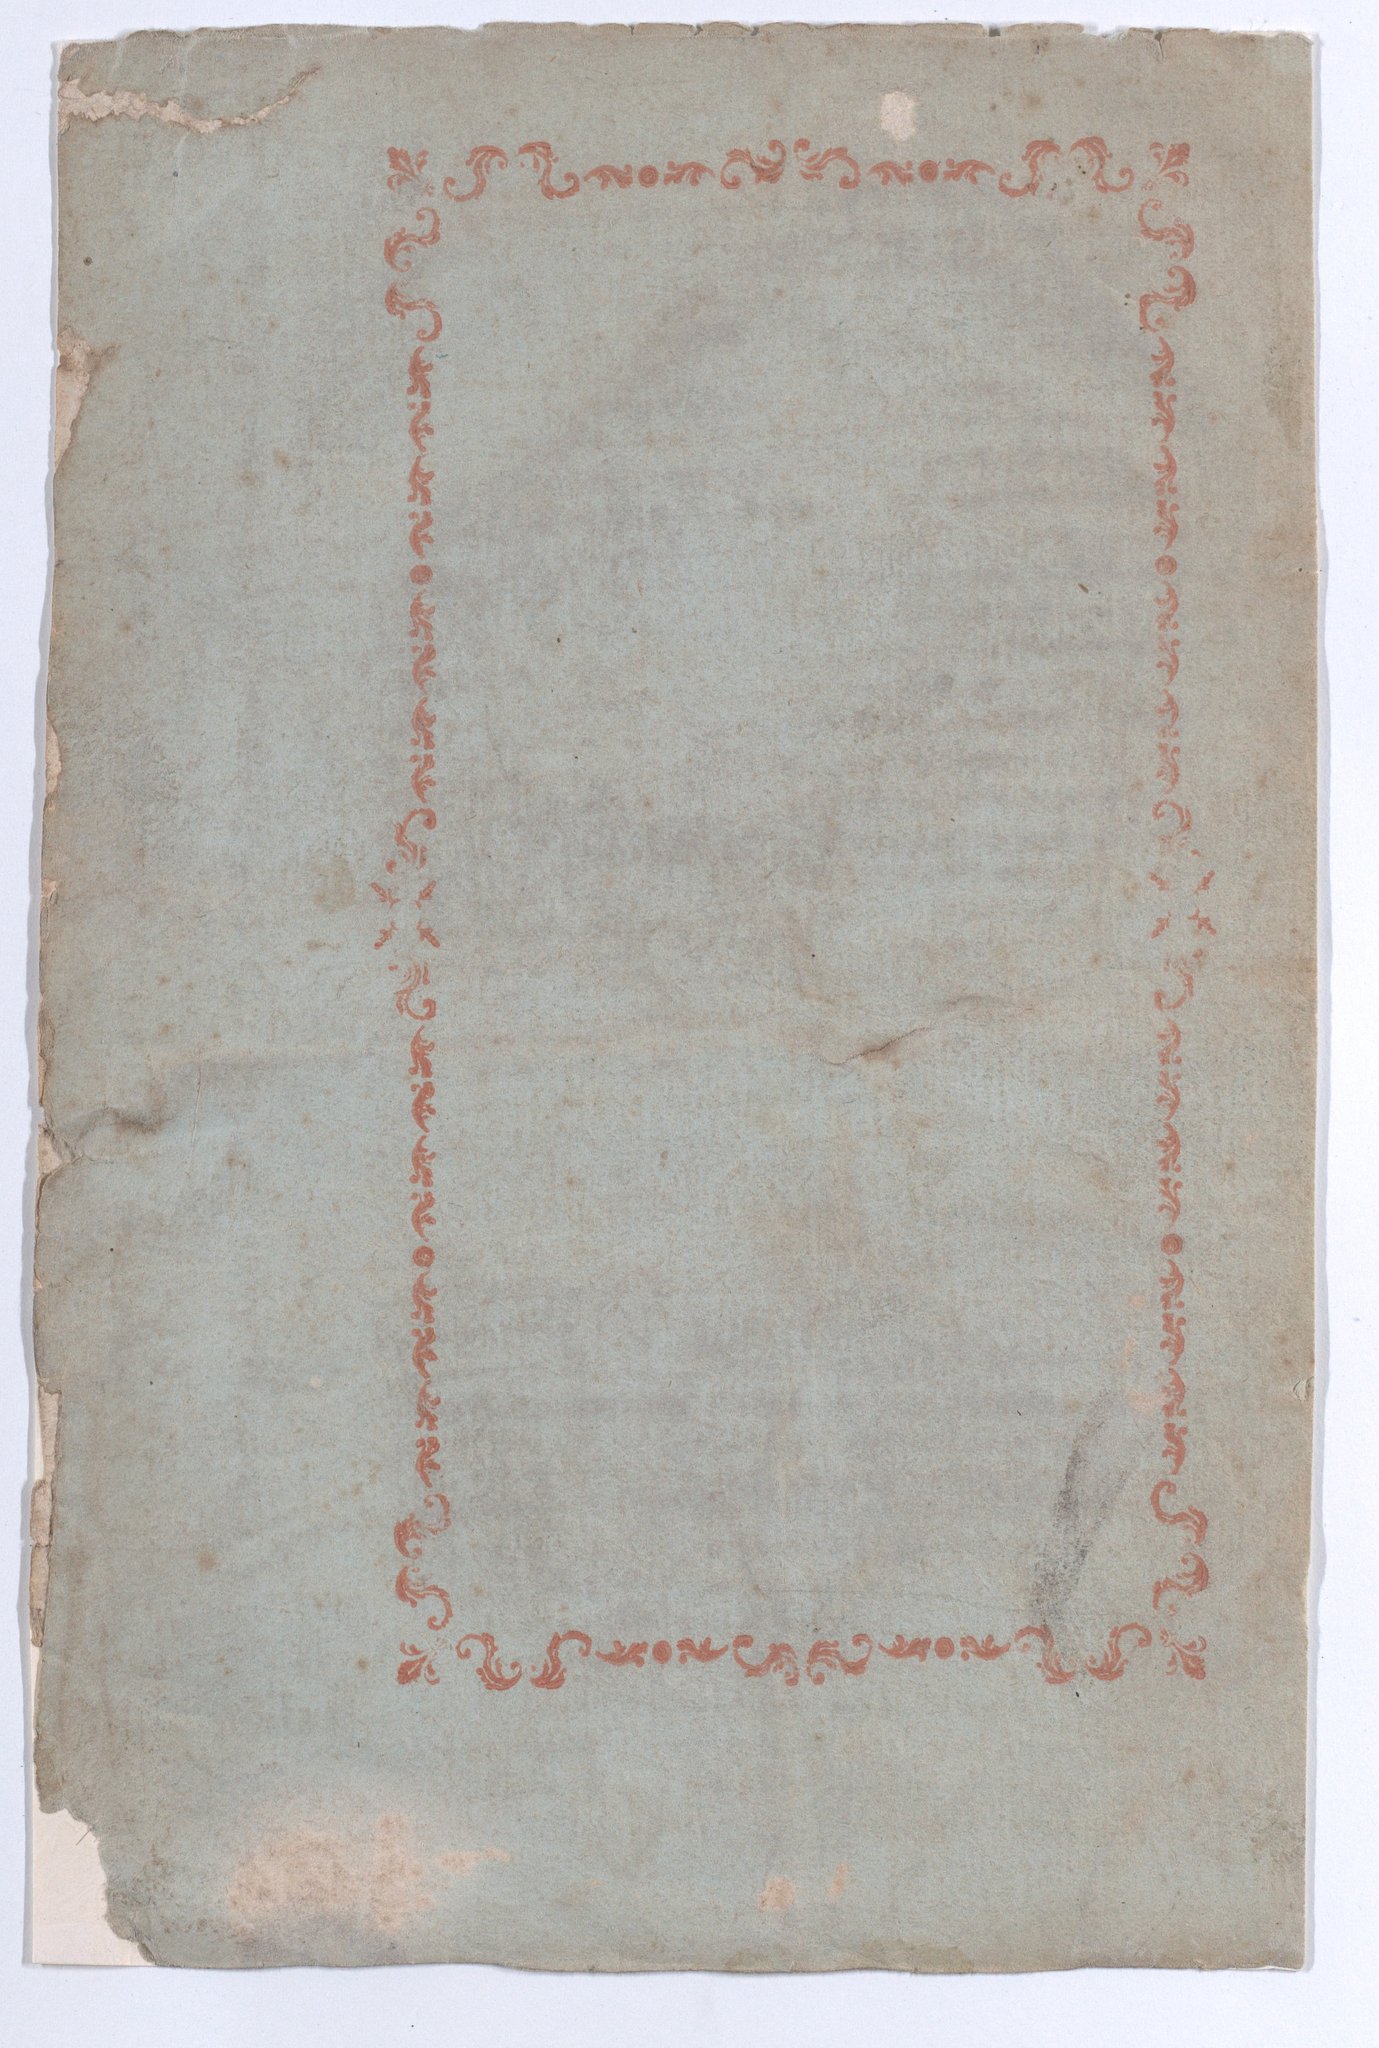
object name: print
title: Sheet with red rectangular design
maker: Anonymous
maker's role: artist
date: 1801-1900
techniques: letterpress